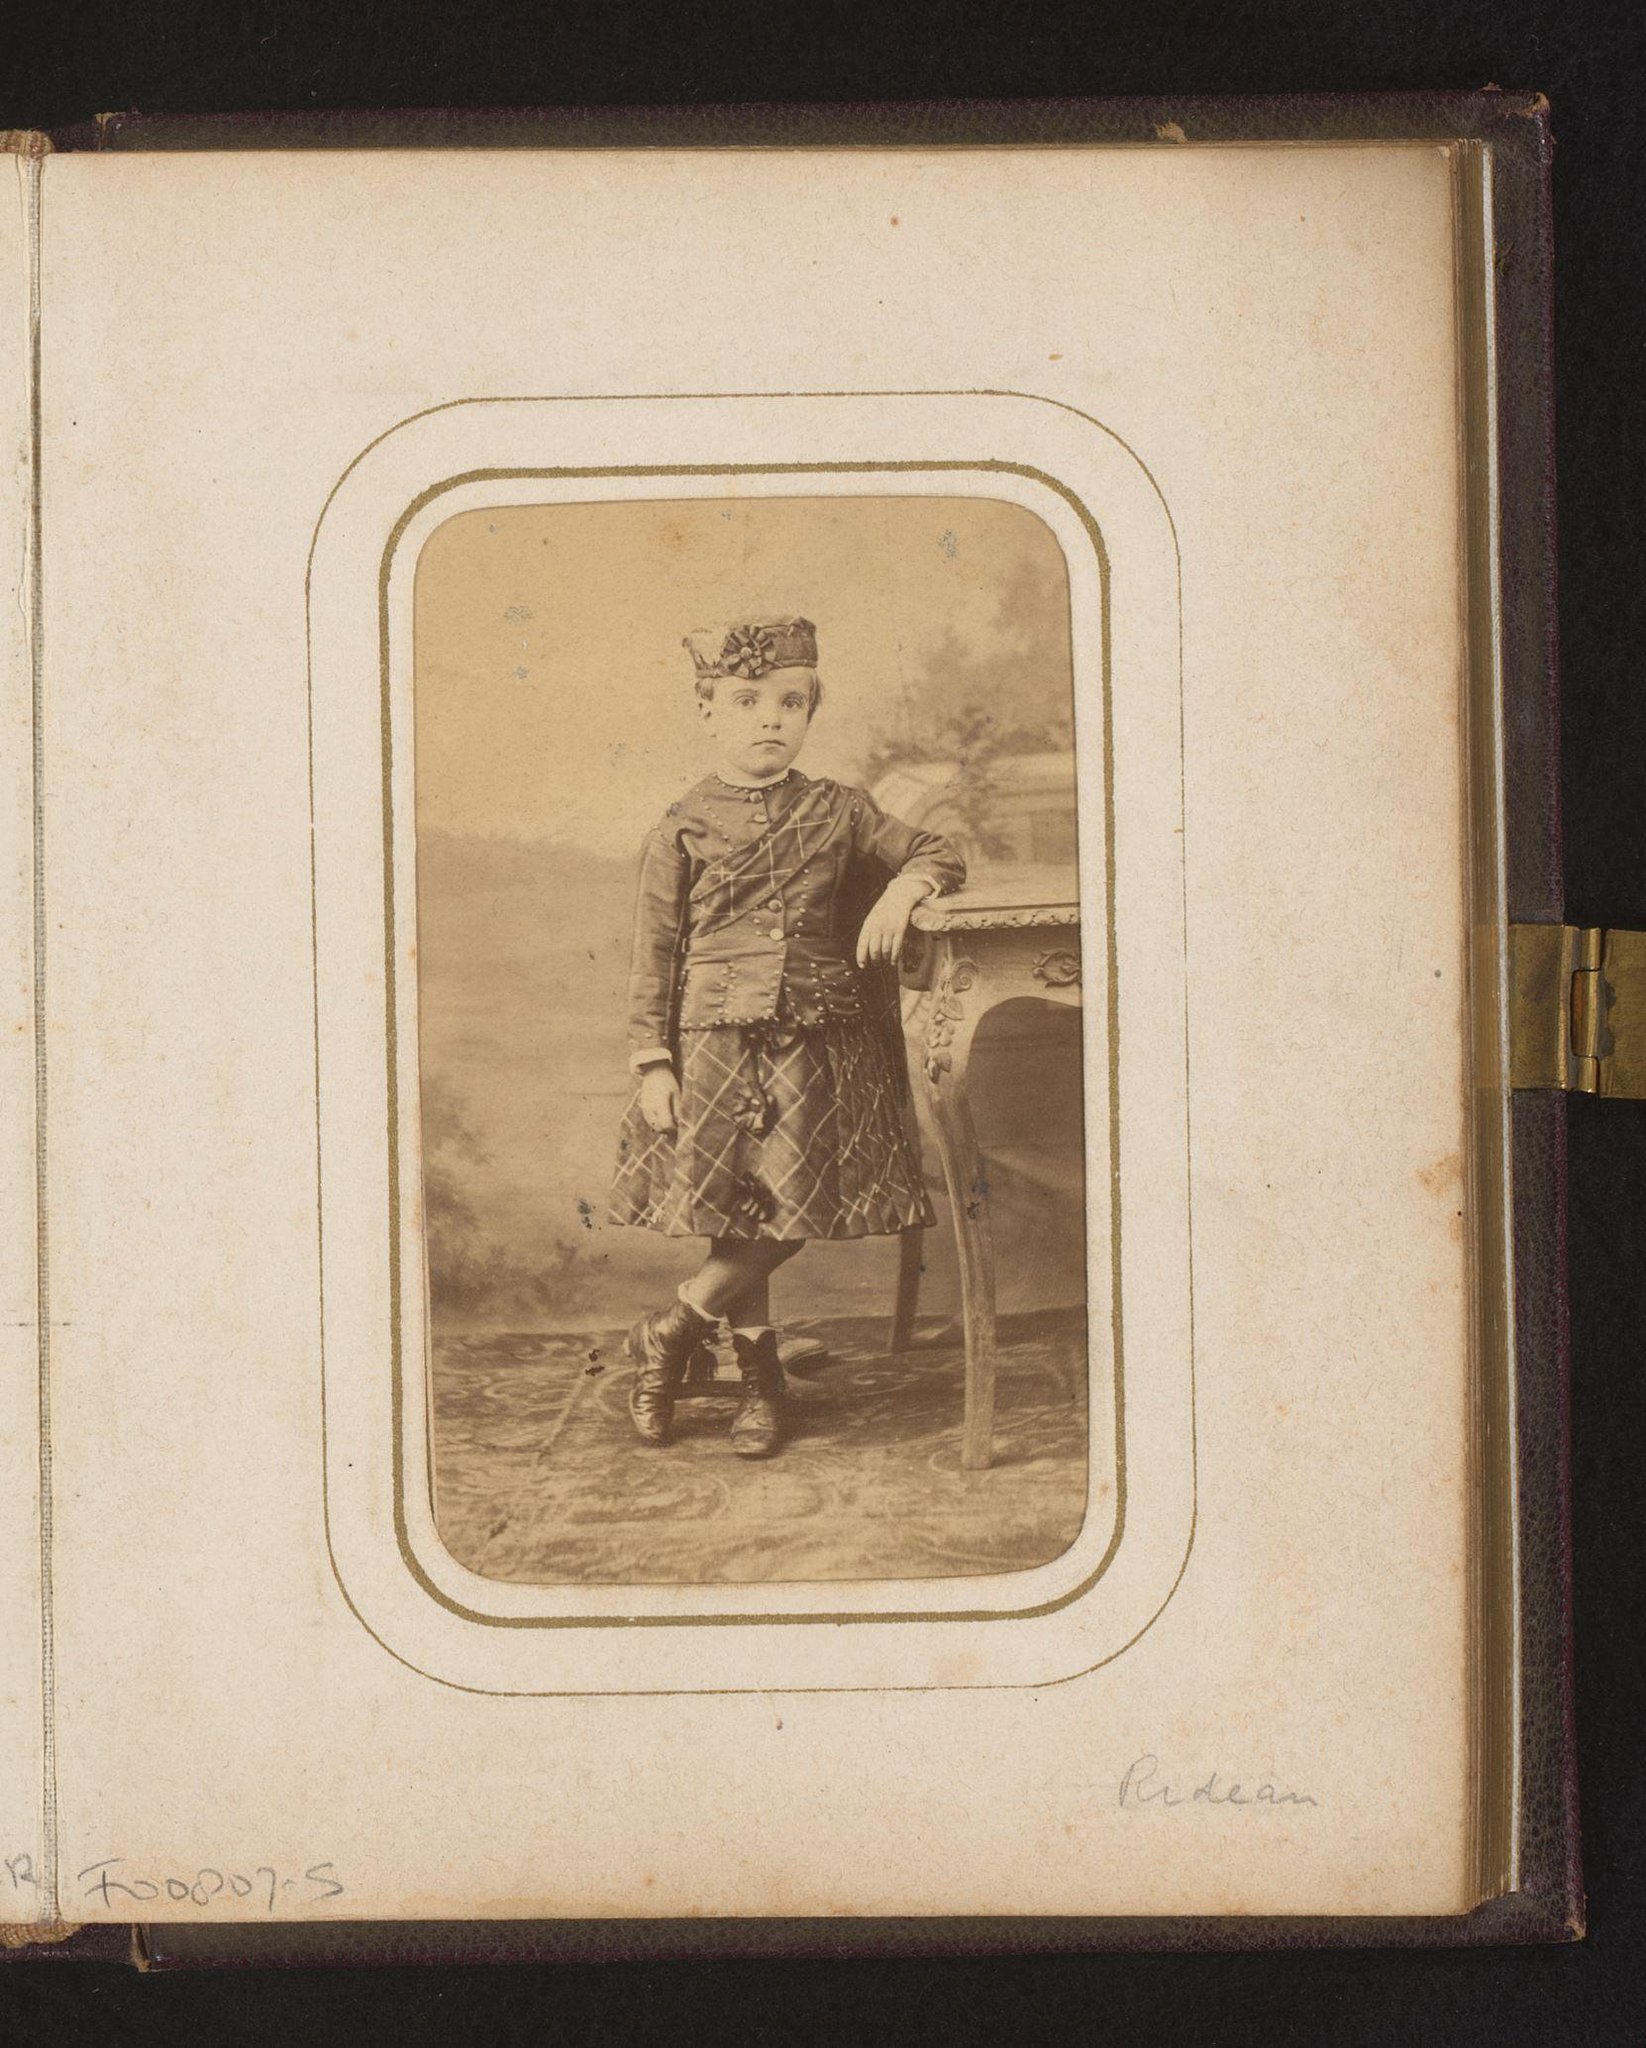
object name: album leaf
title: Portret van een meisje, staand bij een tafel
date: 1868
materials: cardboard, photographic support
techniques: albumen print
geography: cherbourg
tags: historical persons - bb - woman, girl (child between toddler and youth), table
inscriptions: inscription: ‘PORTRAITS ARTISTIQUES/ Maison Rideau/ 38, Quai de Caligny, 38/ CHERBOURG/ on obtiendra de semblables cartes/ en renvoyant une épreuve.’, annotation: ‘Rideau’, annotation: ‘André [..] le 12 Juin/ 1862 [...] 17 Marz/ 1869-/ photographié/ le 28 [...]/ 1868’